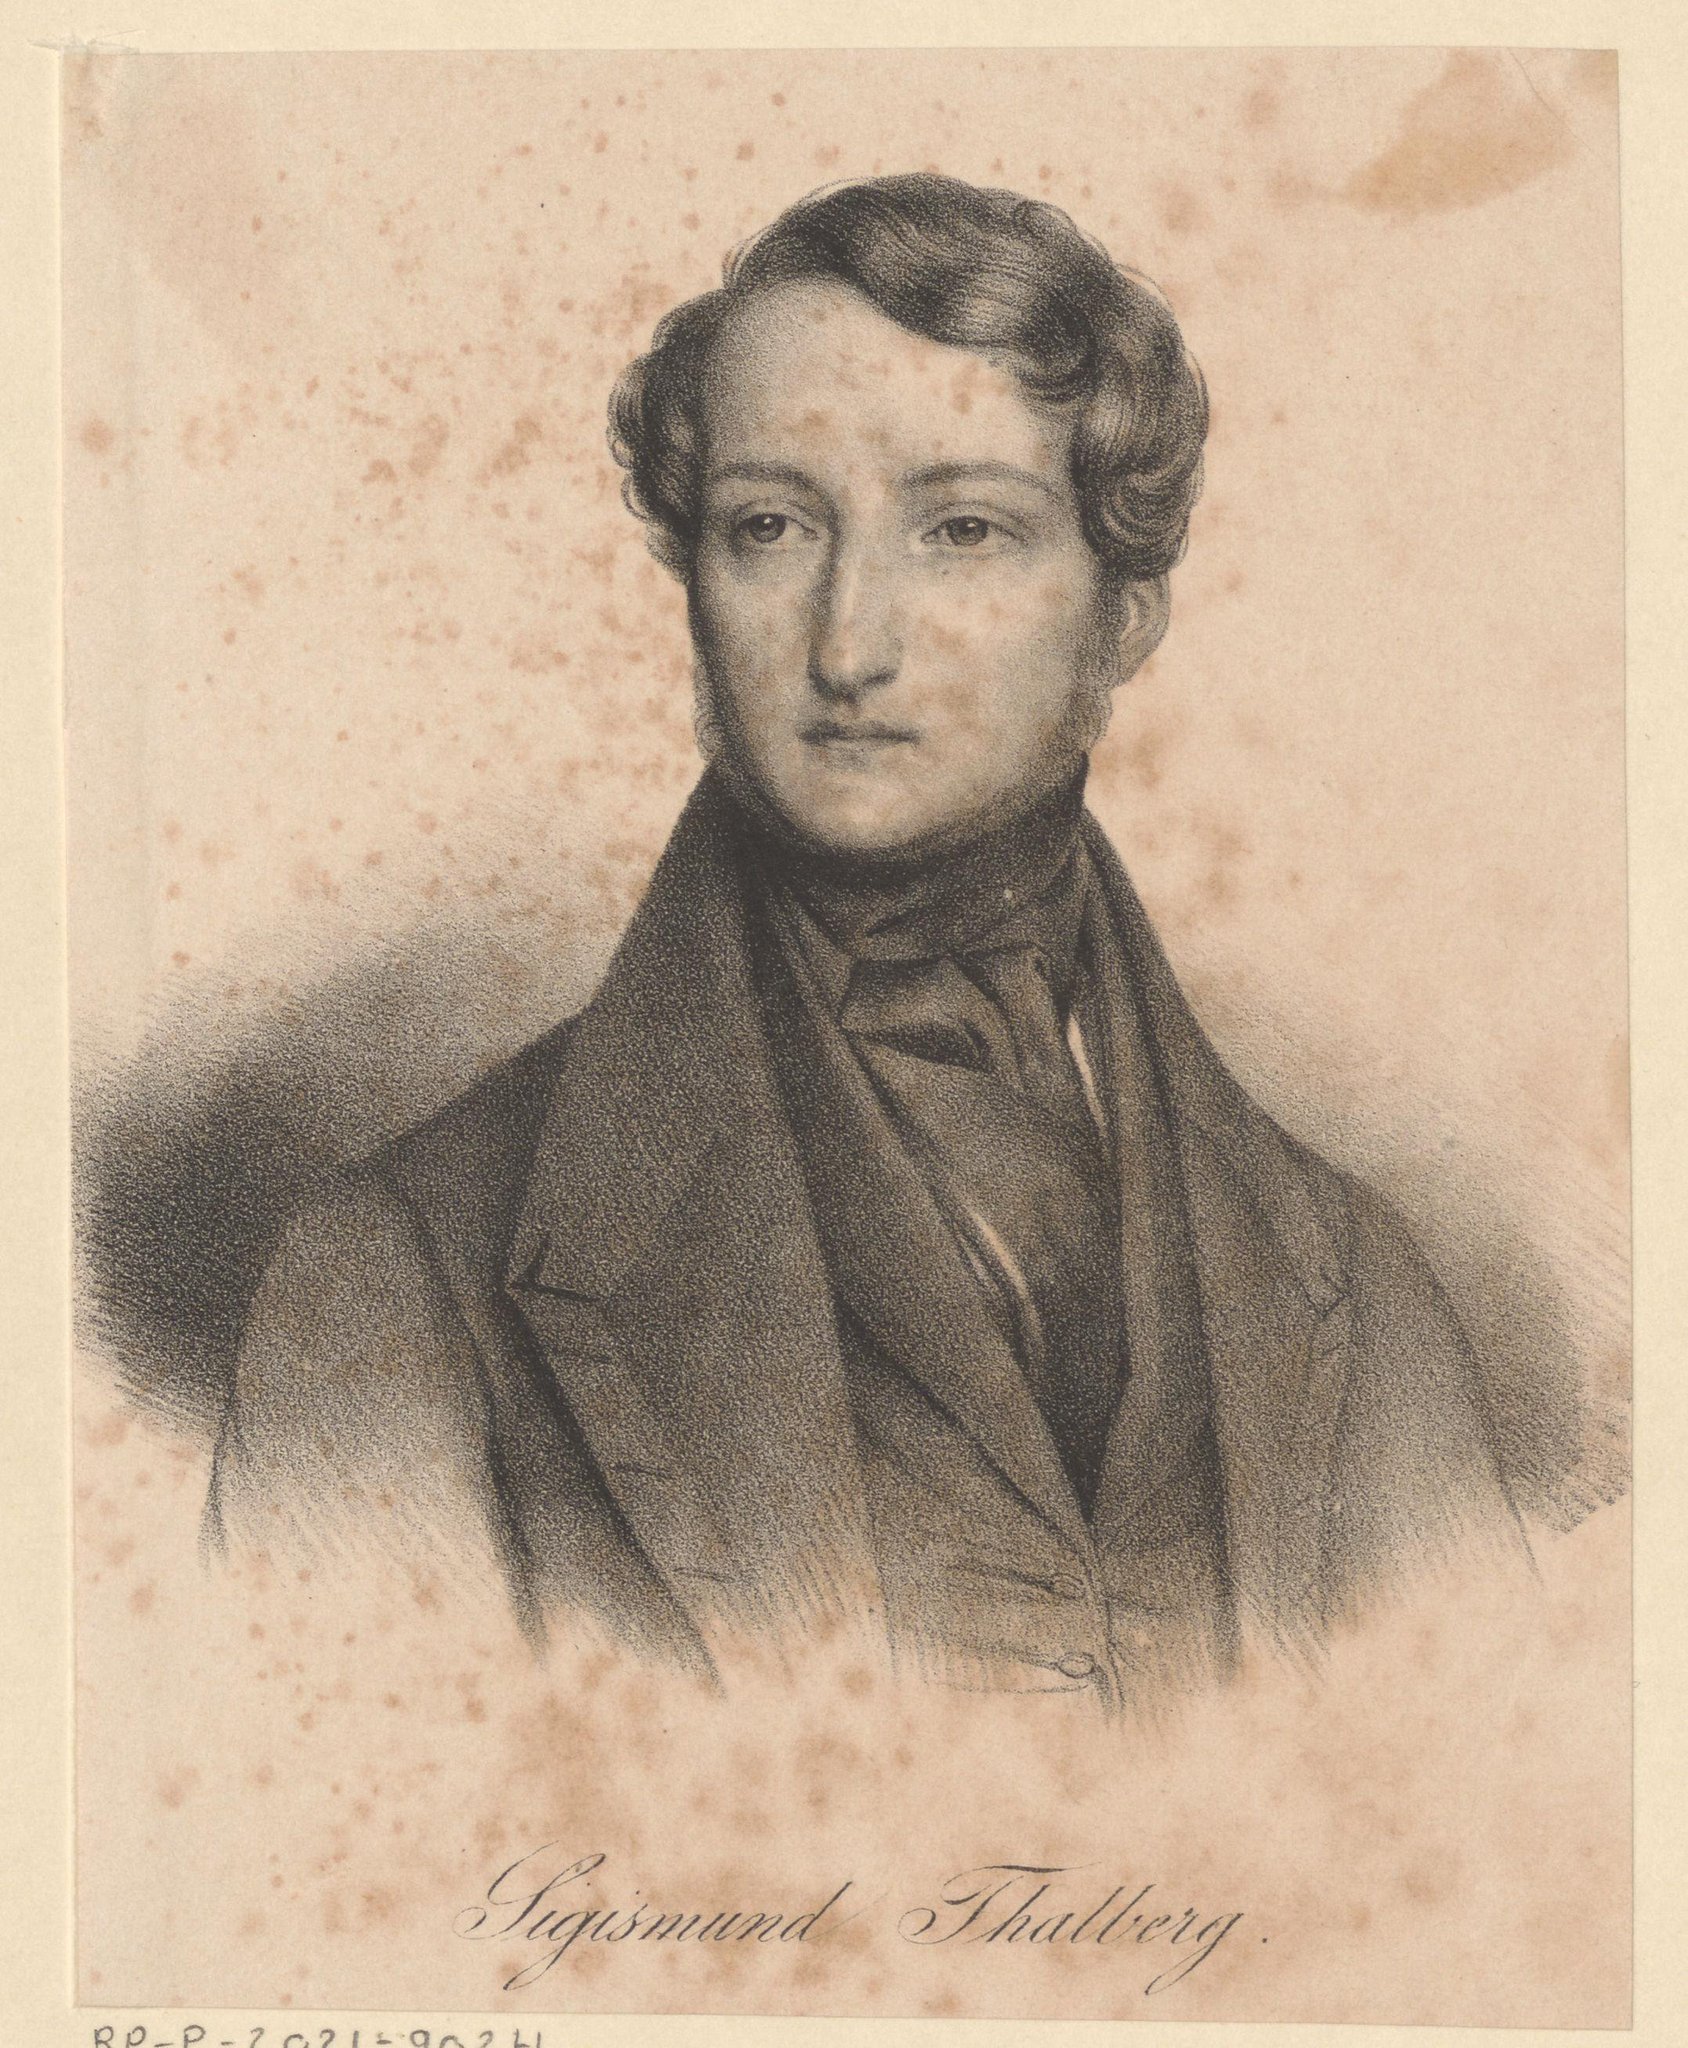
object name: print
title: Portret van Sigismund Thalberg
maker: Anonymous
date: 1840-1860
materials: paper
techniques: lithograph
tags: posillipo, collina di, historical persons, portrait of composer